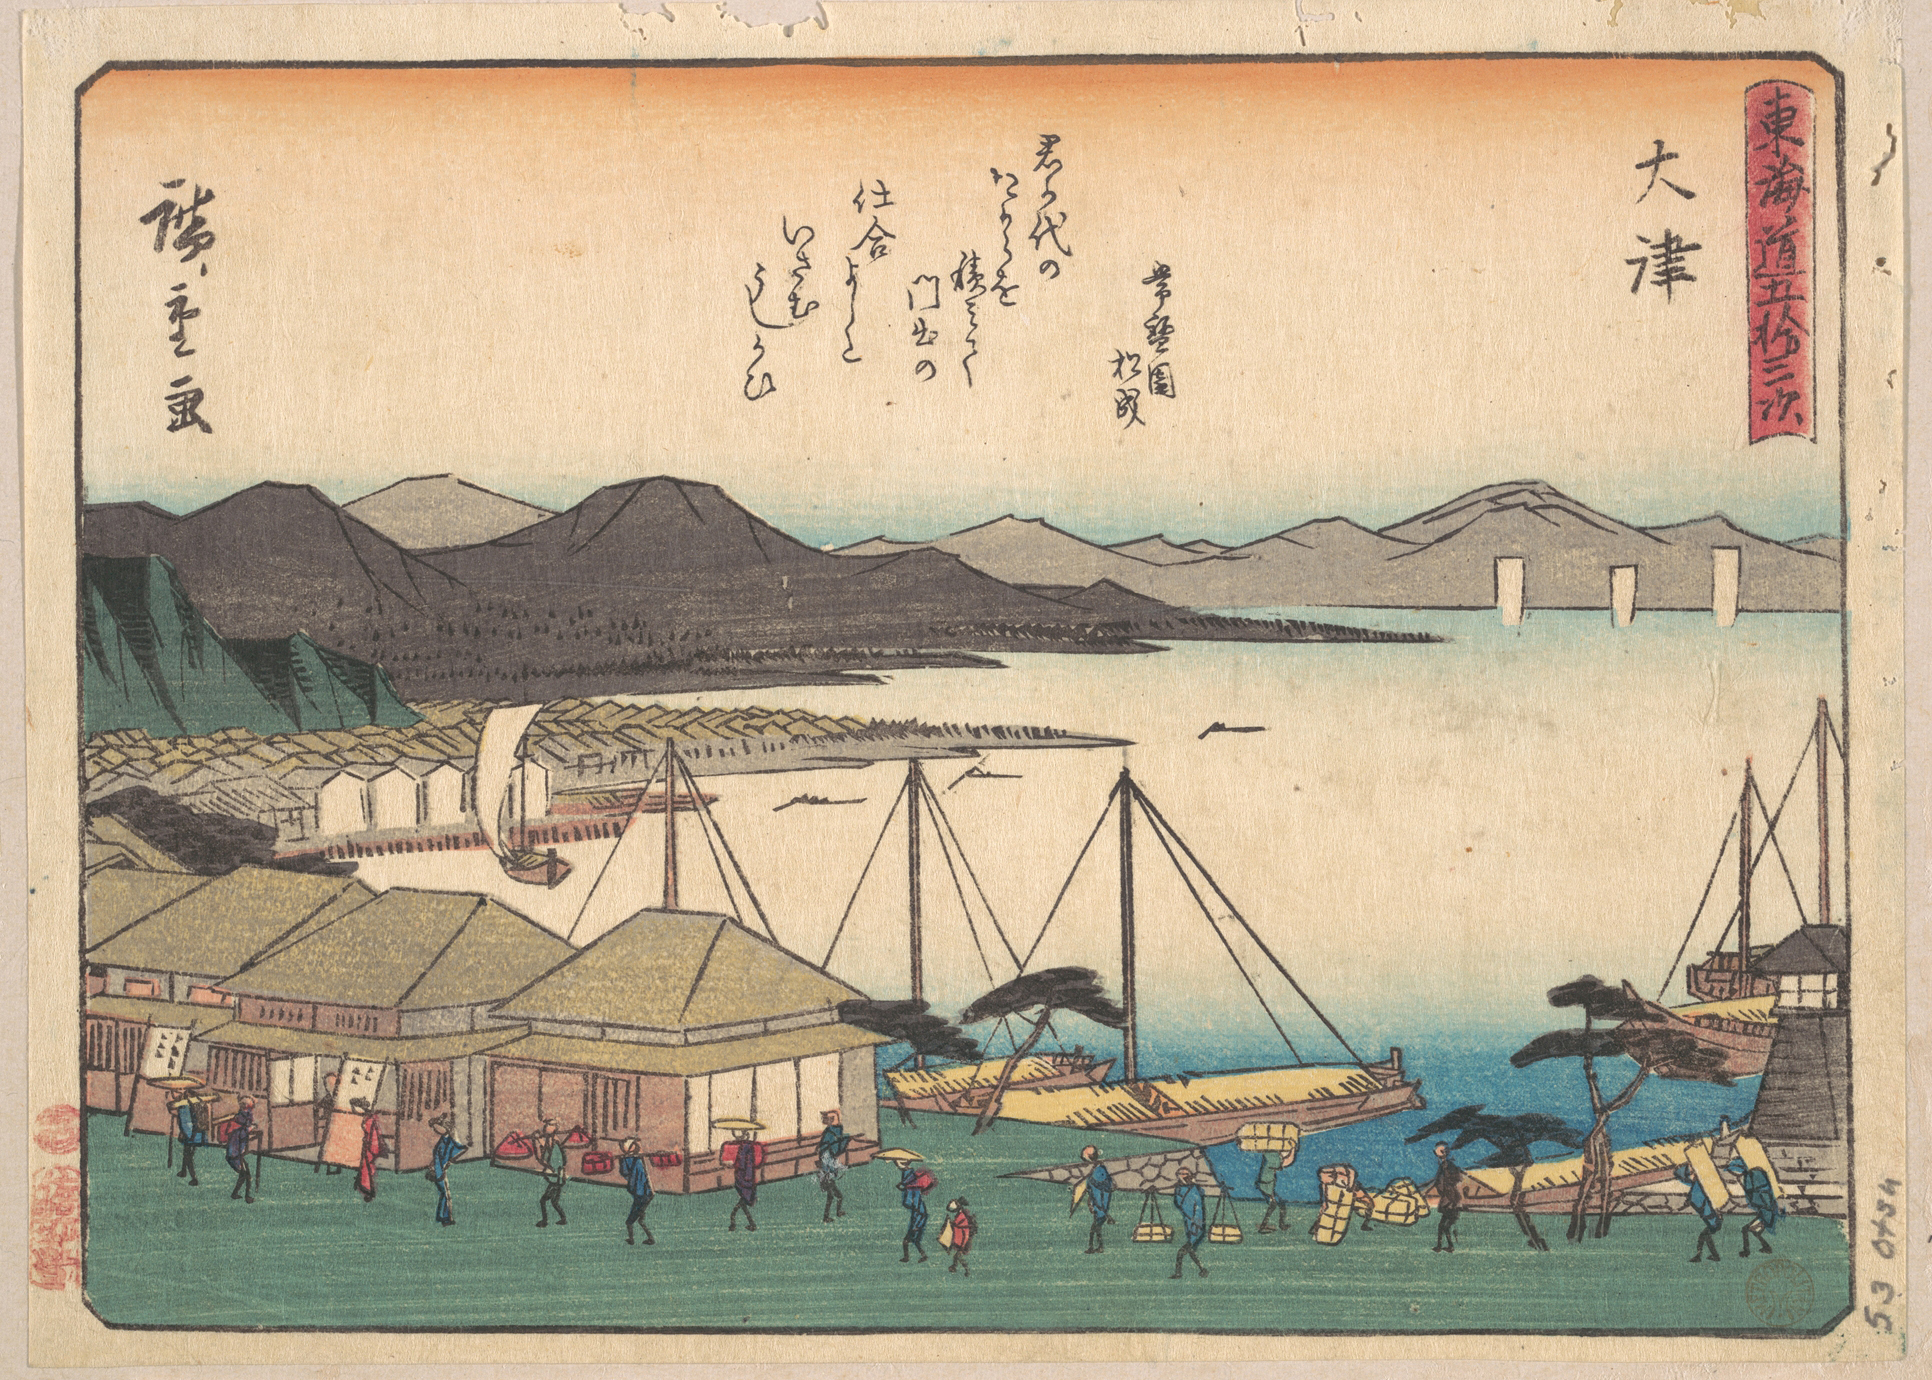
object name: print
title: Otsu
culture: japanese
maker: utagawa hiroshige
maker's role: artist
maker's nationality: japanese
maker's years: 1797-1858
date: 1838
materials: ink, paper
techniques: woodblock print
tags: houses,mountains,trees,ships